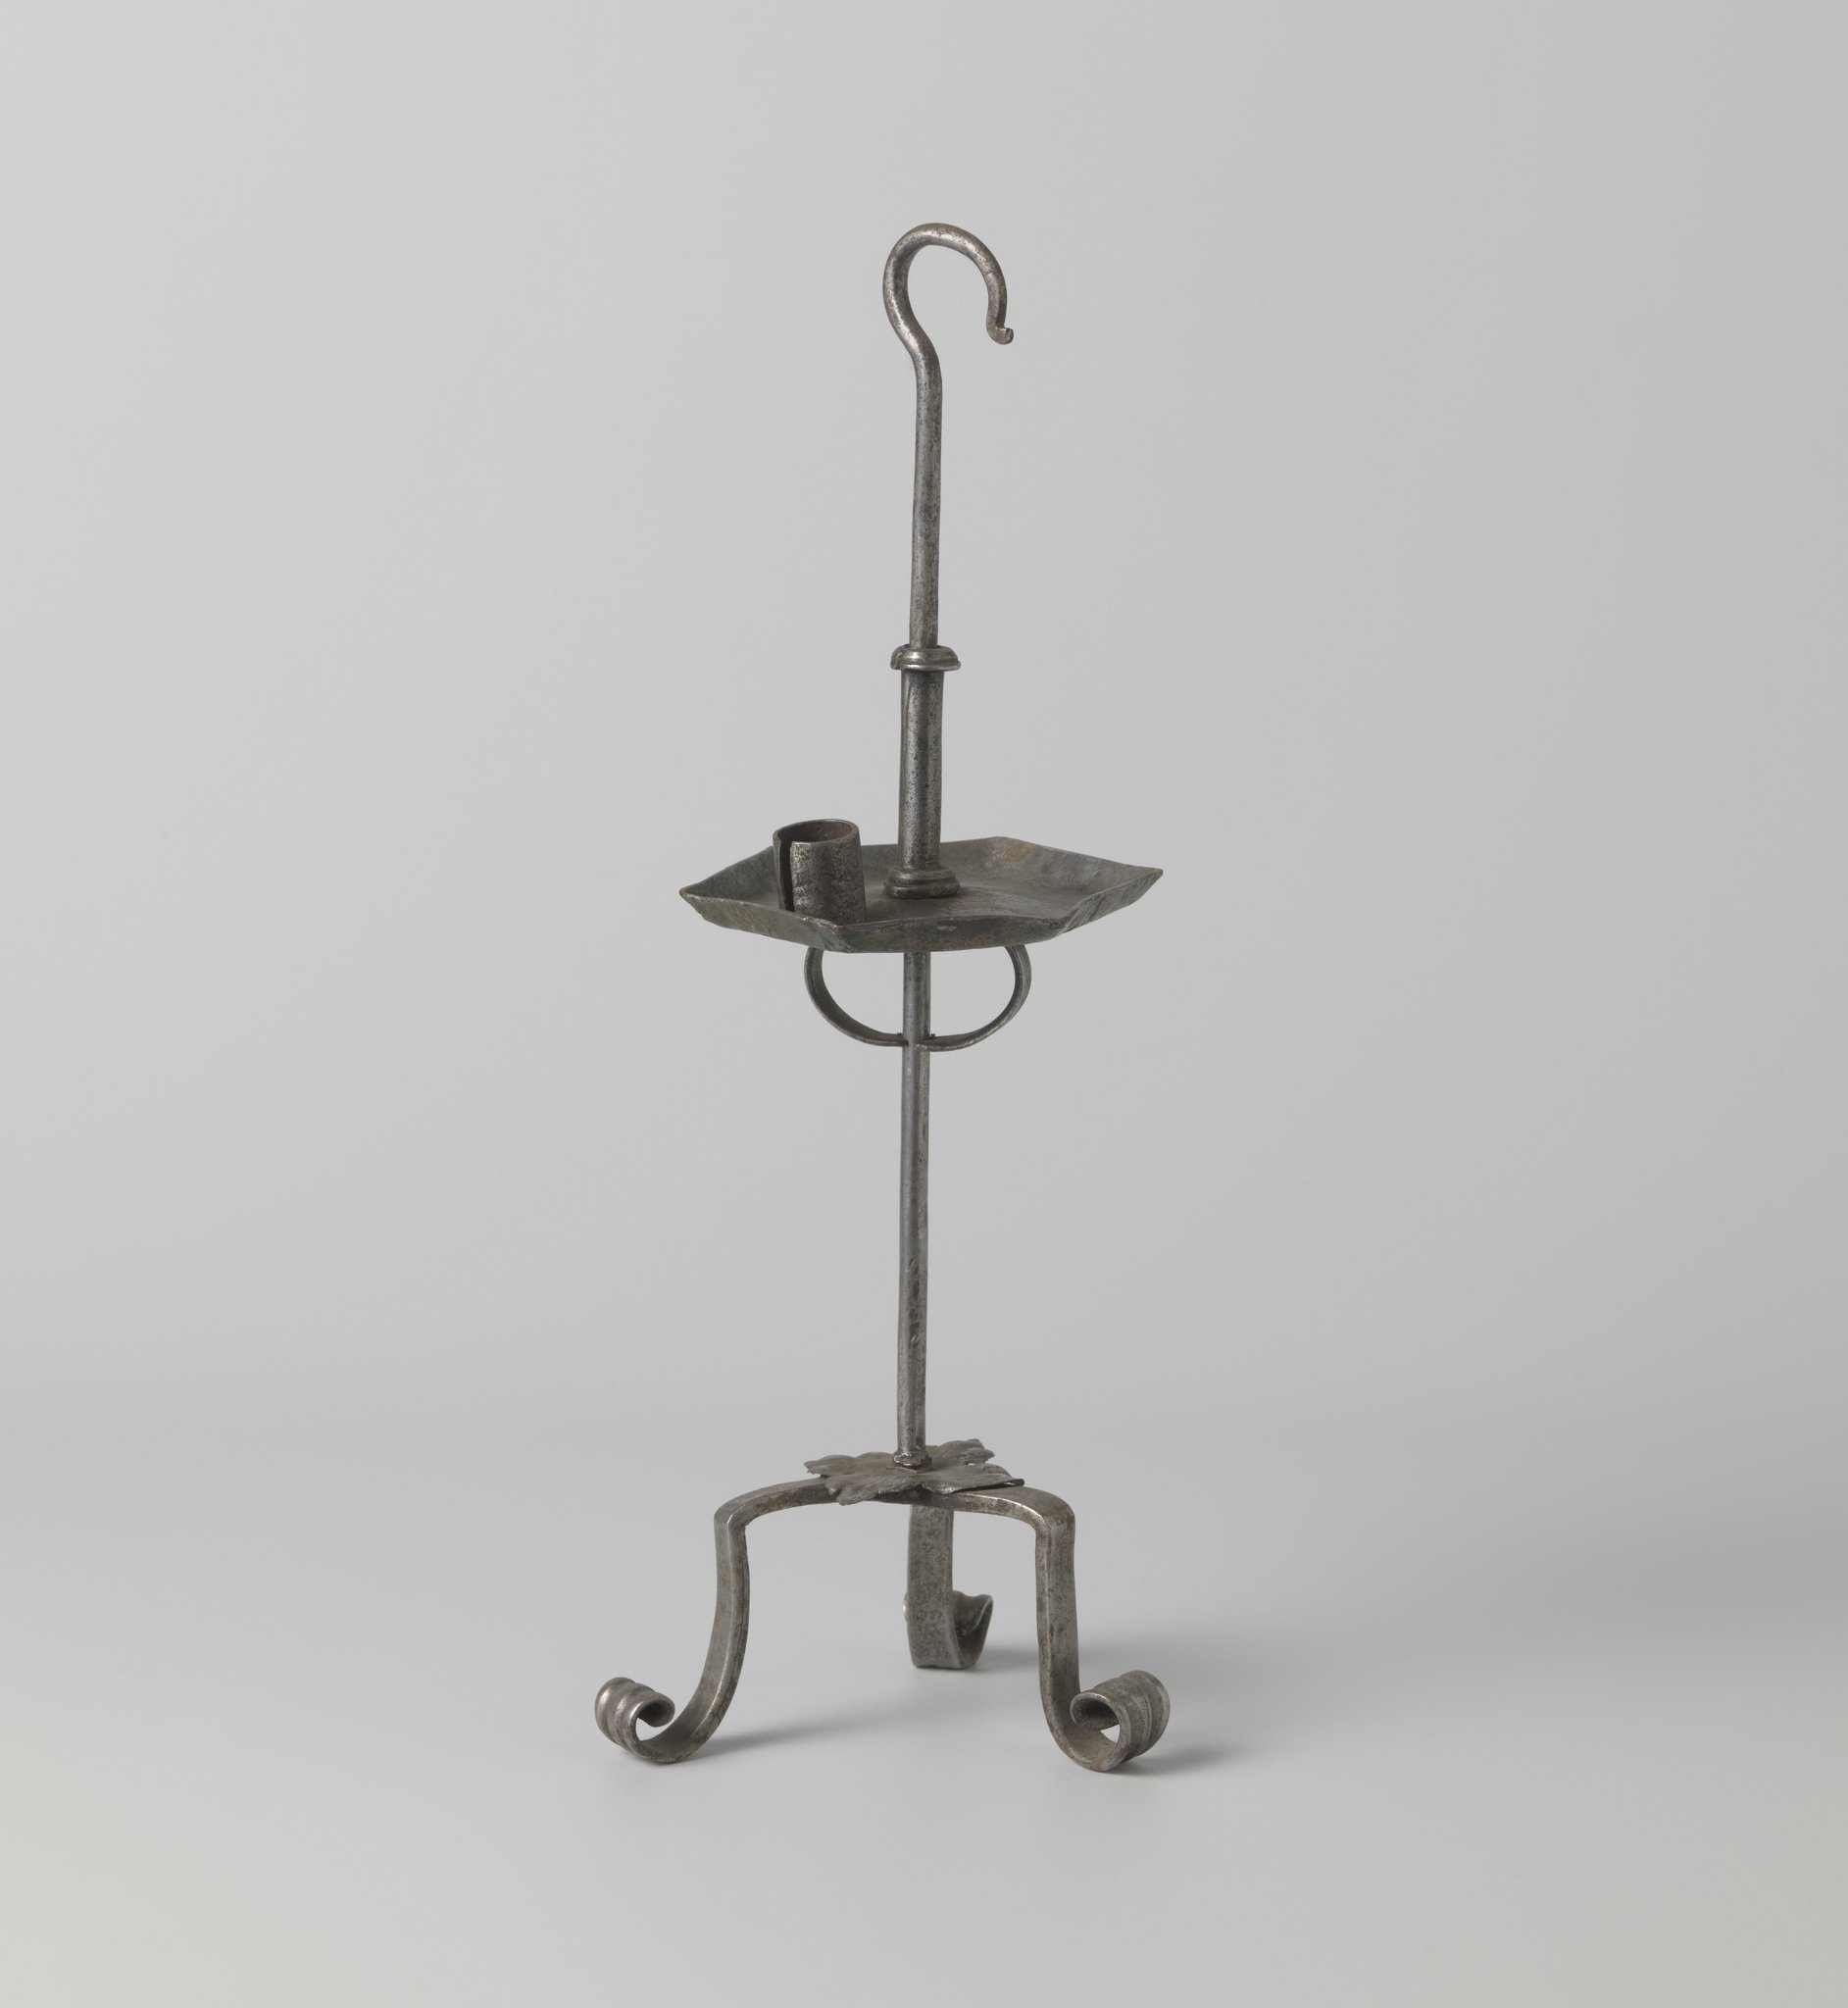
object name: candlestick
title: kandelaar om te hangen en om te staan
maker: Anonymous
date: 1500-1700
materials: iron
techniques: forging, riveted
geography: germany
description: Kandelaar van ijzer op drie poten, die in een scherpe hoek naar beneden lopen en waarvan de iets wijdere, gecanneleerde uiteinden omkrullen. Op de poten is de ronde, staafvormige stam geklonken met daartussen een vierkant plaatje in de vorm van een blad. Halverwege de stam is een platte reep, die in twee halve cirkels naar beneden krult. Daarboven is de zeshoekige vetvanger geplaats, met aan de rand de kaarsenhouder en in het midden een staaf, die bovenaan eindigt in een haak, waardoor de kandelaar ook hangend dienst kan doen.